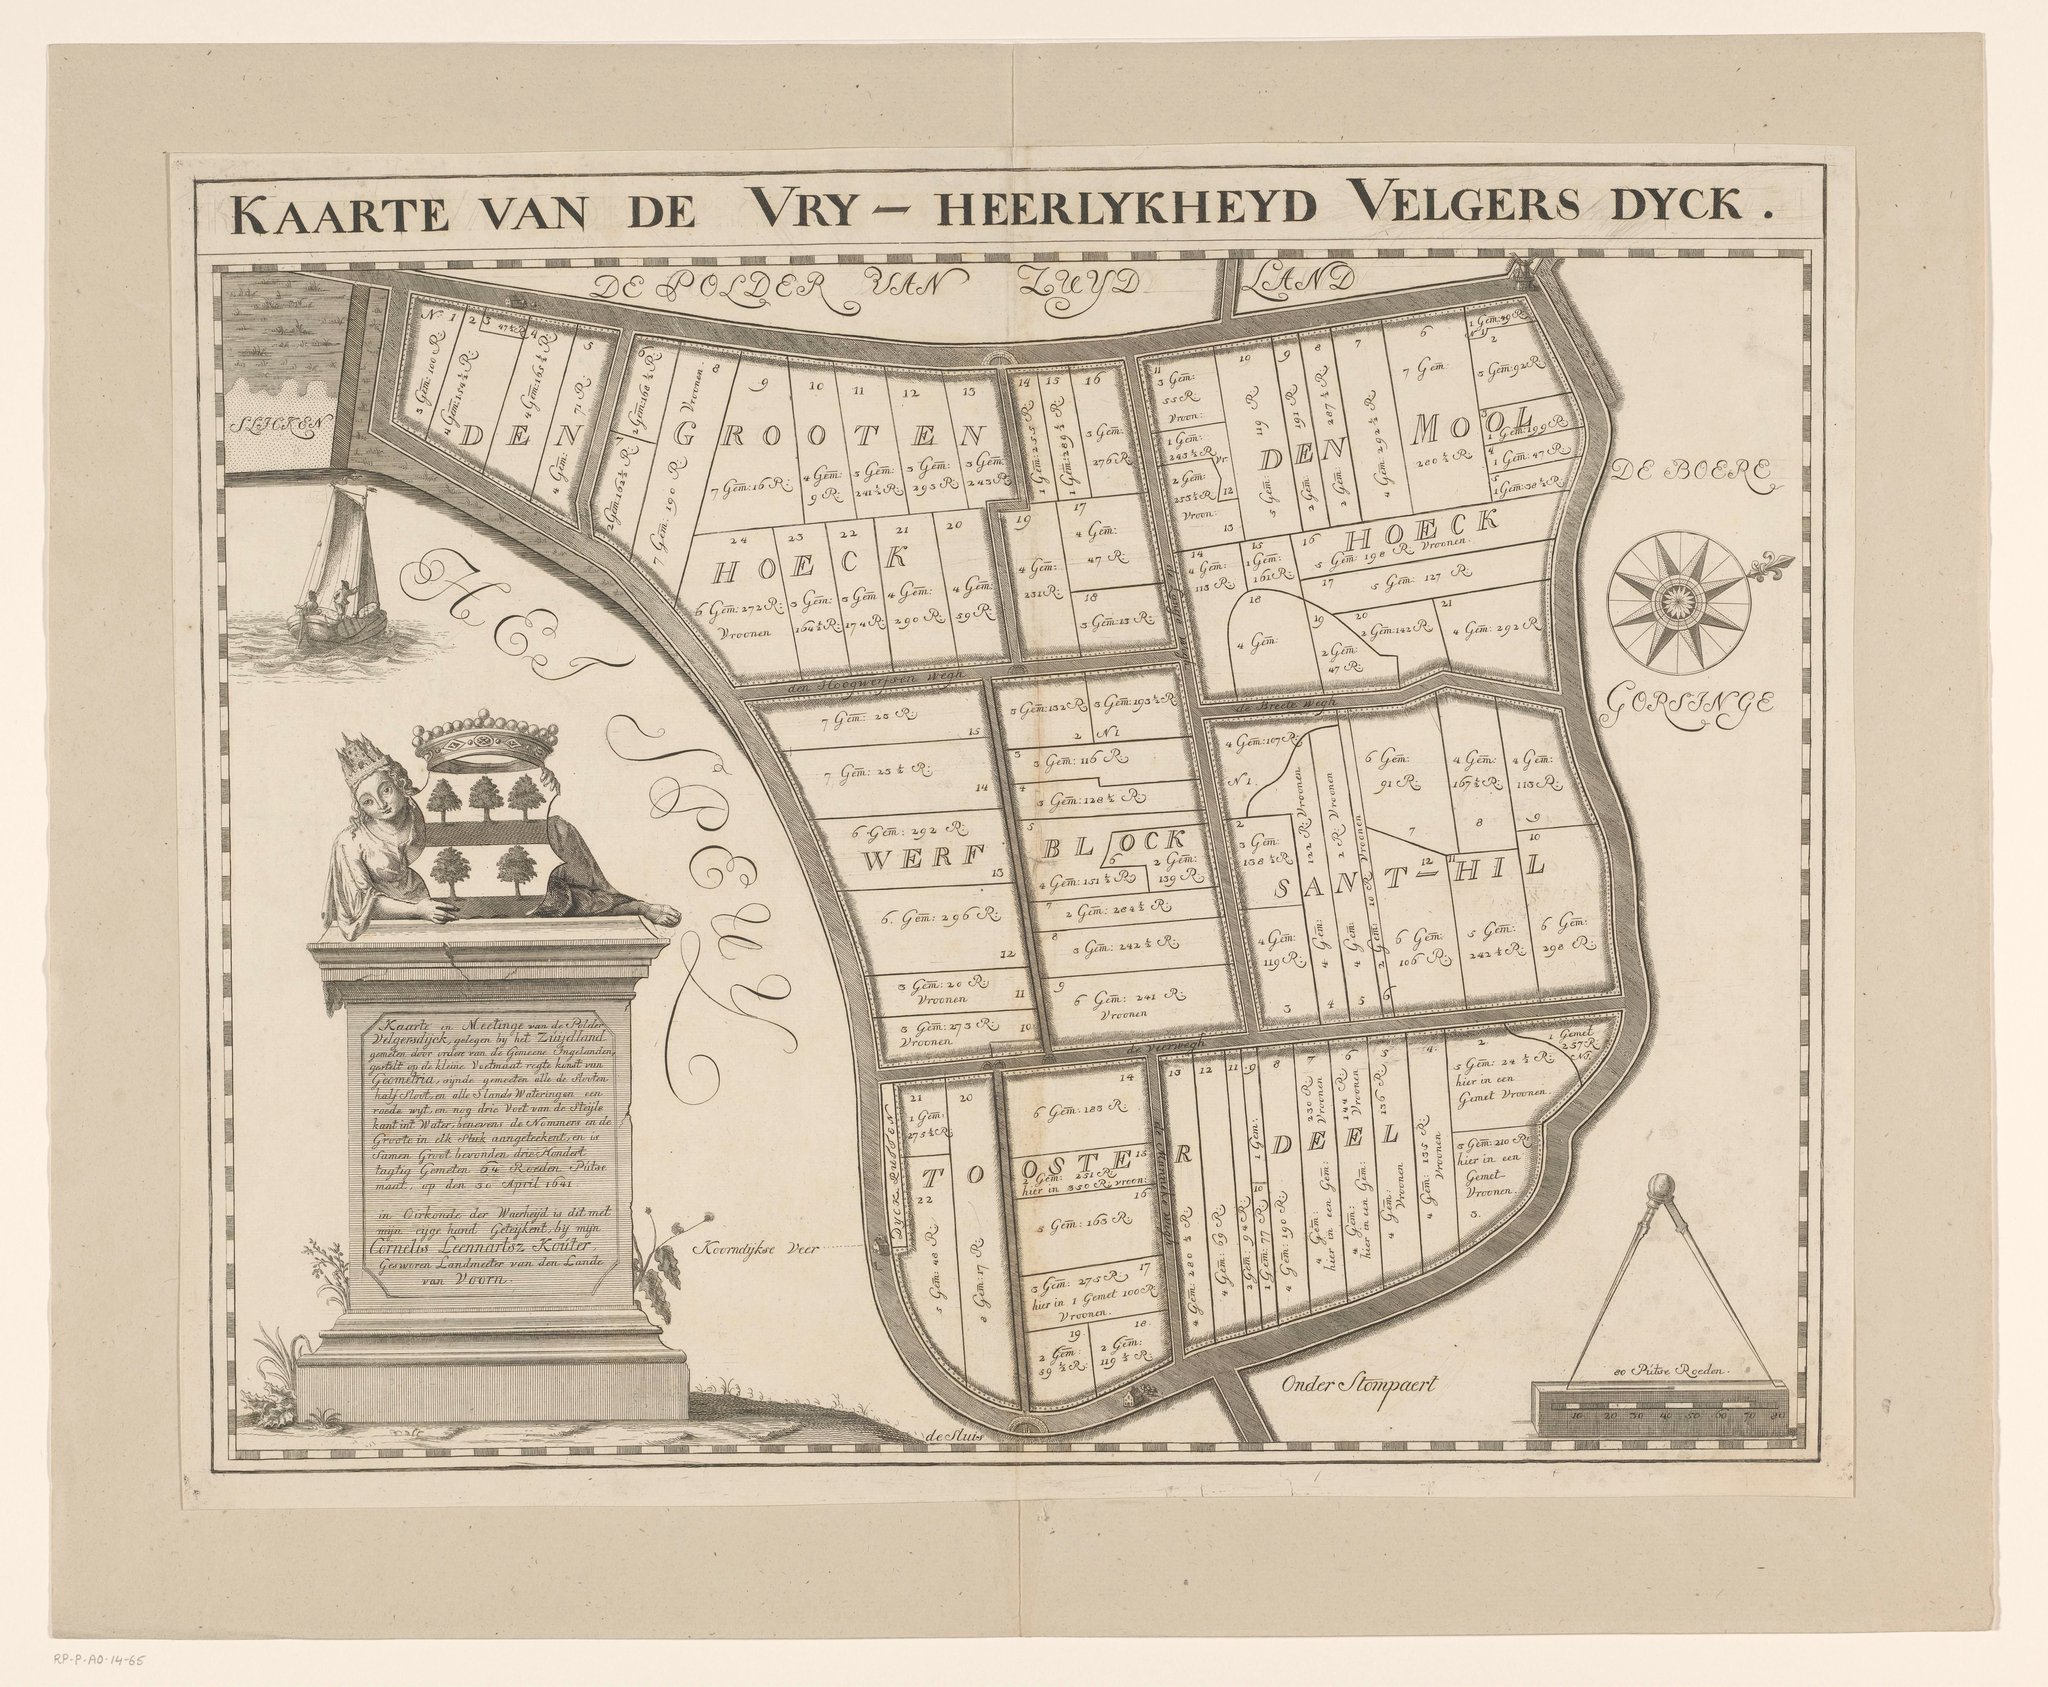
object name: map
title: Kaart van de polder Velgersdijk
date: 1641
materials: paper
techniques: engraving, etching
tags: coat of arms (as symbol of the state, etc.), maps of separate countries or regions, polder, reclaimed land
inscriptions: date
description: Kaart van de polder Velgersdijk. Langs de bovenkant de eerste titel. Links een cartouche met de tweede titel en informatie en daarboven een vrouwfiguur met het wapen van de polder. Rechtsonder een schaalstok: 80 Putse roeden.